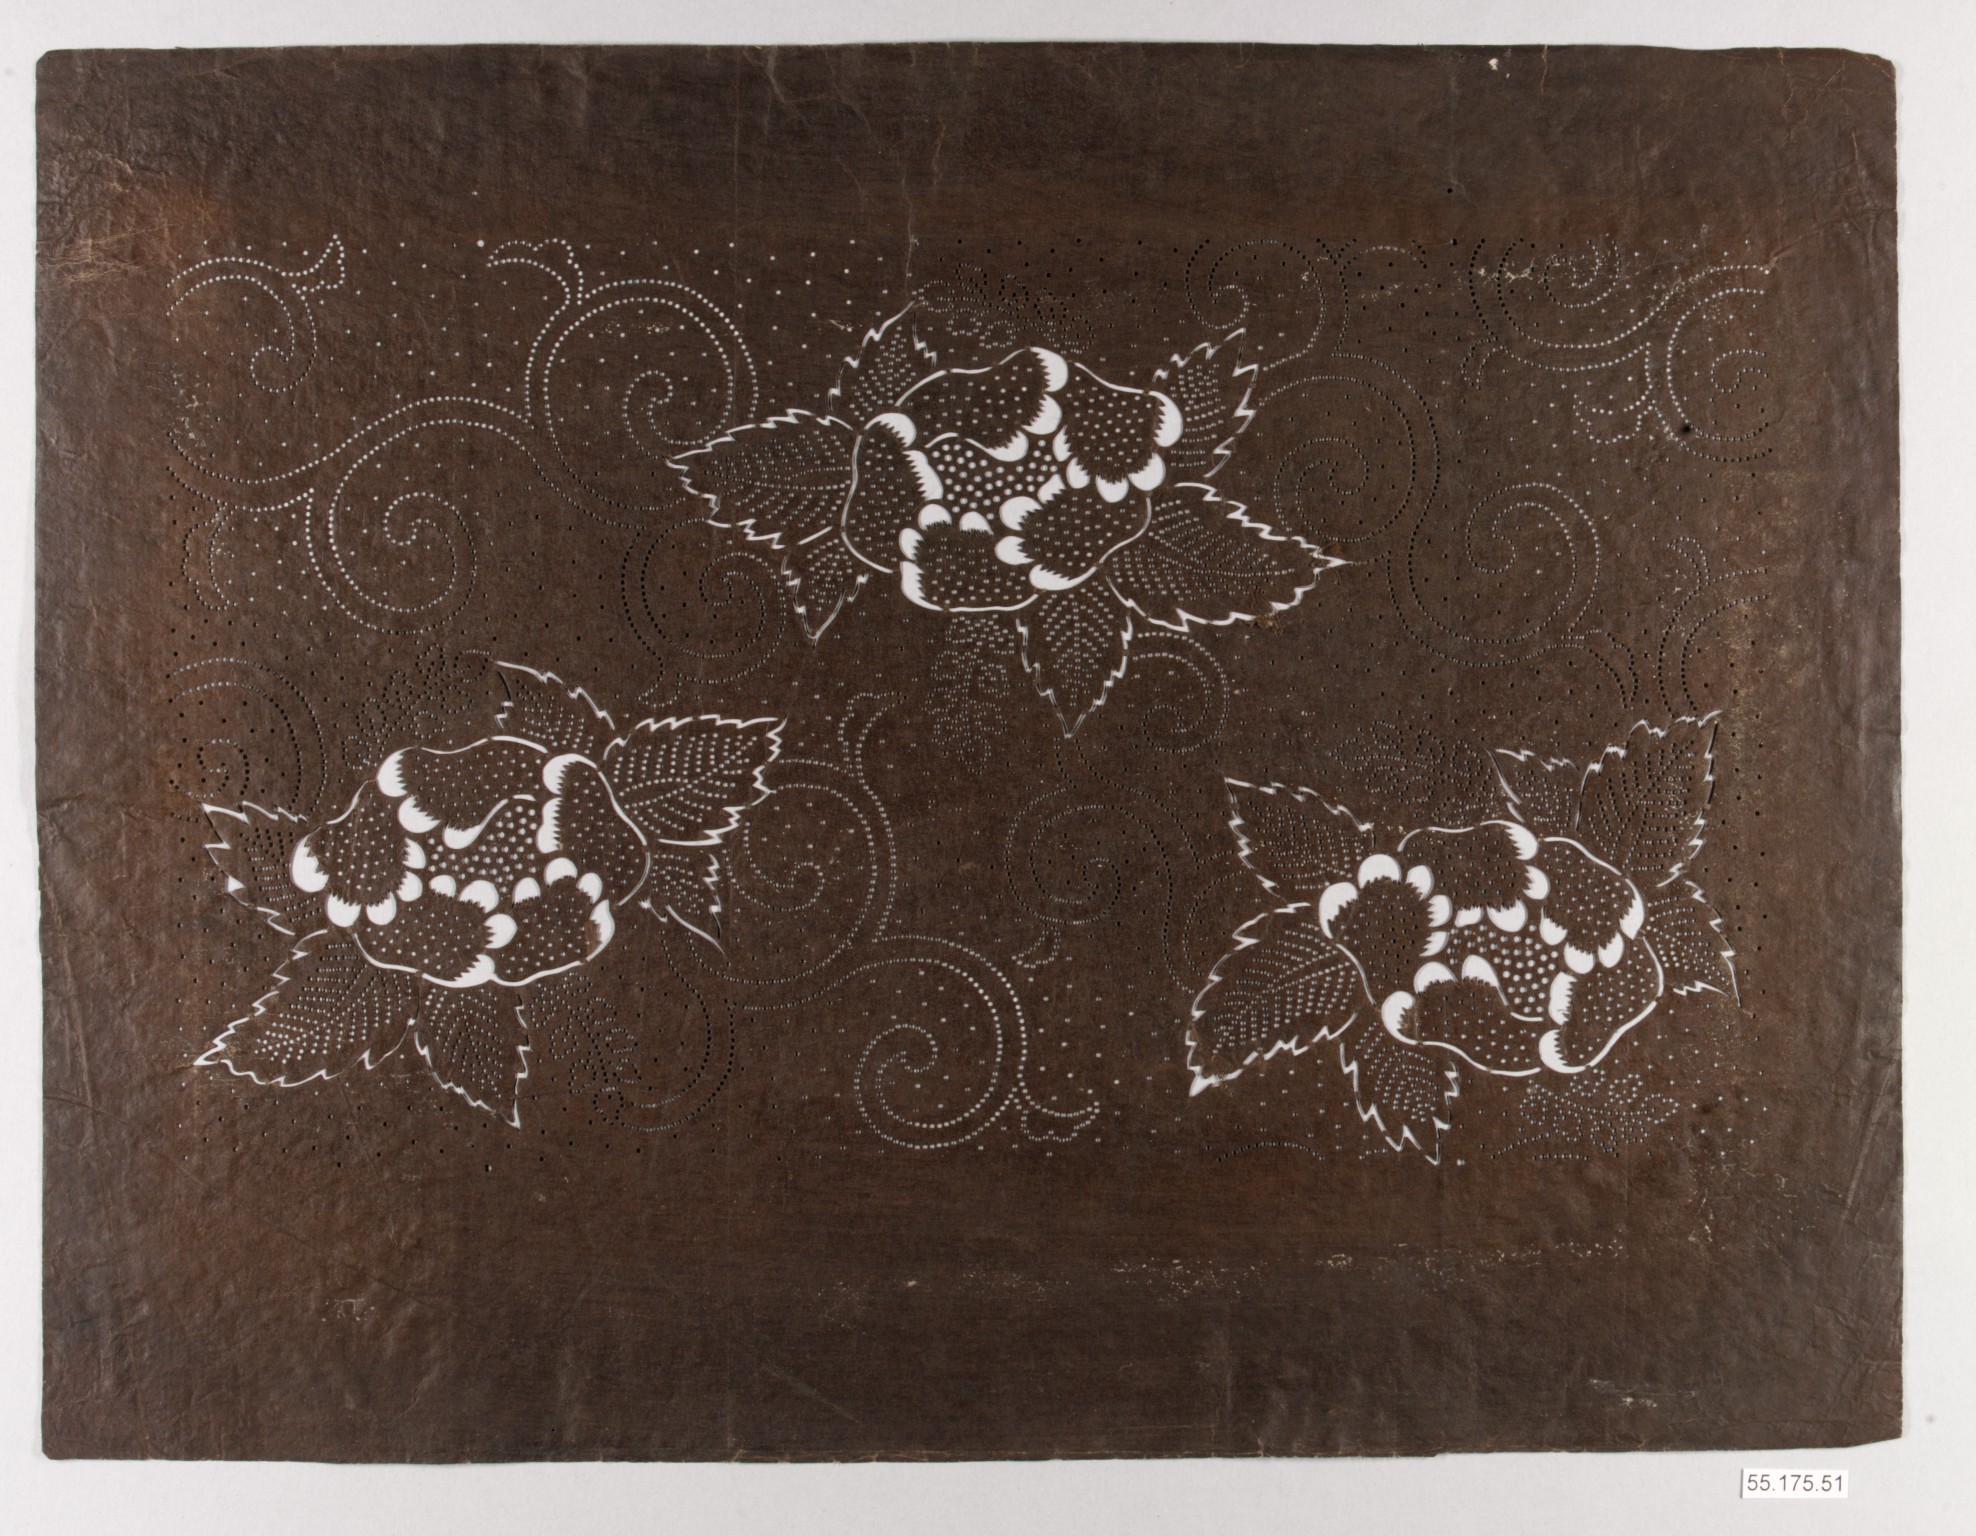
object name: stencil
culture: japanese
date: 1801-1900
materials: paper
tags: flowers